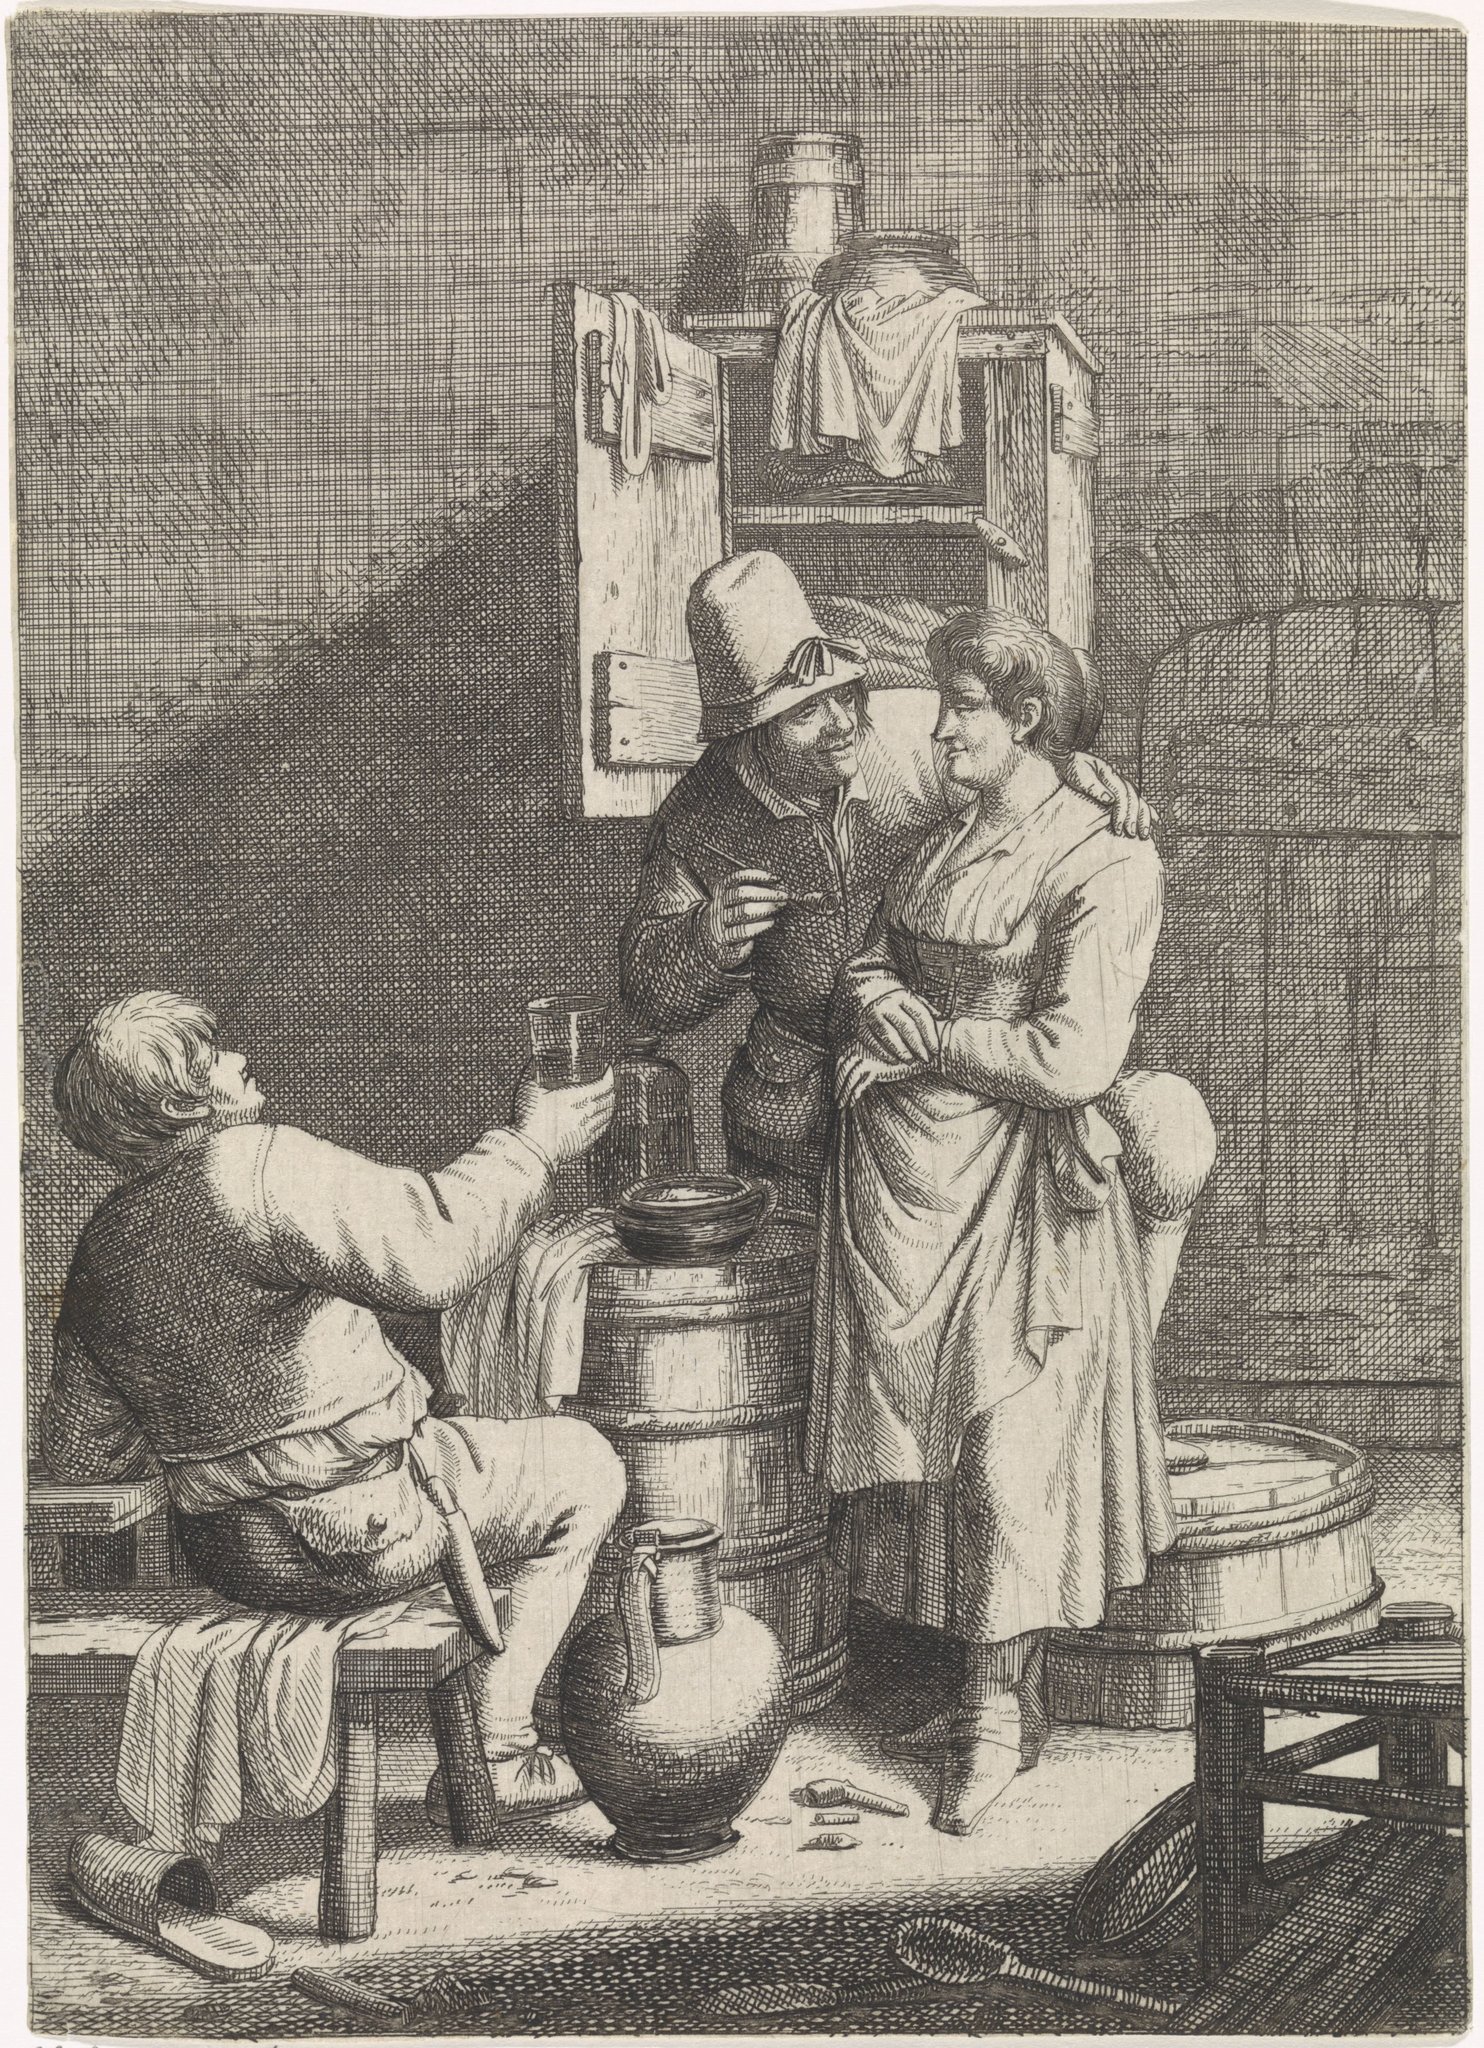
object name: print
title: Boerenpaar en een man met een glas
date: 1635-1692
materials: paper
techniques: engraving, etching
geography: prague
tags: pipe ~ tobacco, farmers, glass, rummer, couple of lovers, farm (building) - aa - civic architecture: inside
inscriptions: collector's mark: Lugt 2165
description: In een interieur laat een man zijn hand op de schouder van een vrouw rusten, waarbij zij elkaar aankijken. De man houdt een pijp in de hand. Links zit een boer, op de rug gezien, die zijn glas heft en het paar aankijkt. Naast hem staat een kruik. Aan de muur hangt een houten kast, waarvan de deur openstaat.